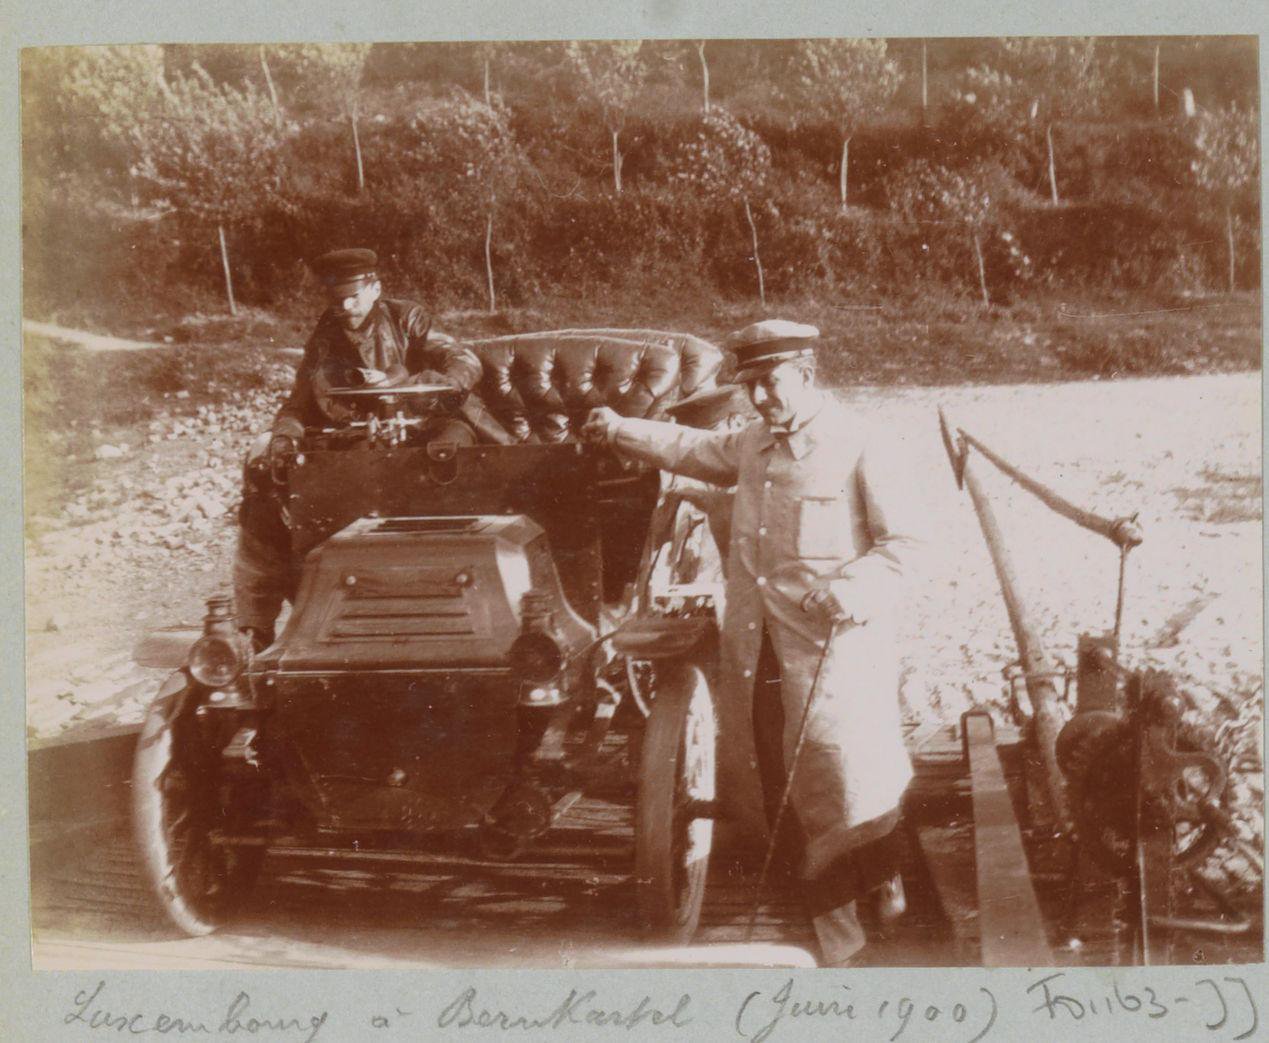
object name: photograph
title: Twee mannen manoevreren een automobiel op een veer te Bernkastel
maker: delizy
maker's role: manufacturer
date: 1900-1906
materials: paper, photographic support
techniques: gelatin silver print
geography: bernkastel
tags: ferry, automobile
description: Onderdeel van Fotoalbum van een Franse amateurfotograaf met opnames van uitstapjes in Frankrijk, Spanje, België, Luxemburg en Nederland, de eerste automobielen en autoraces.